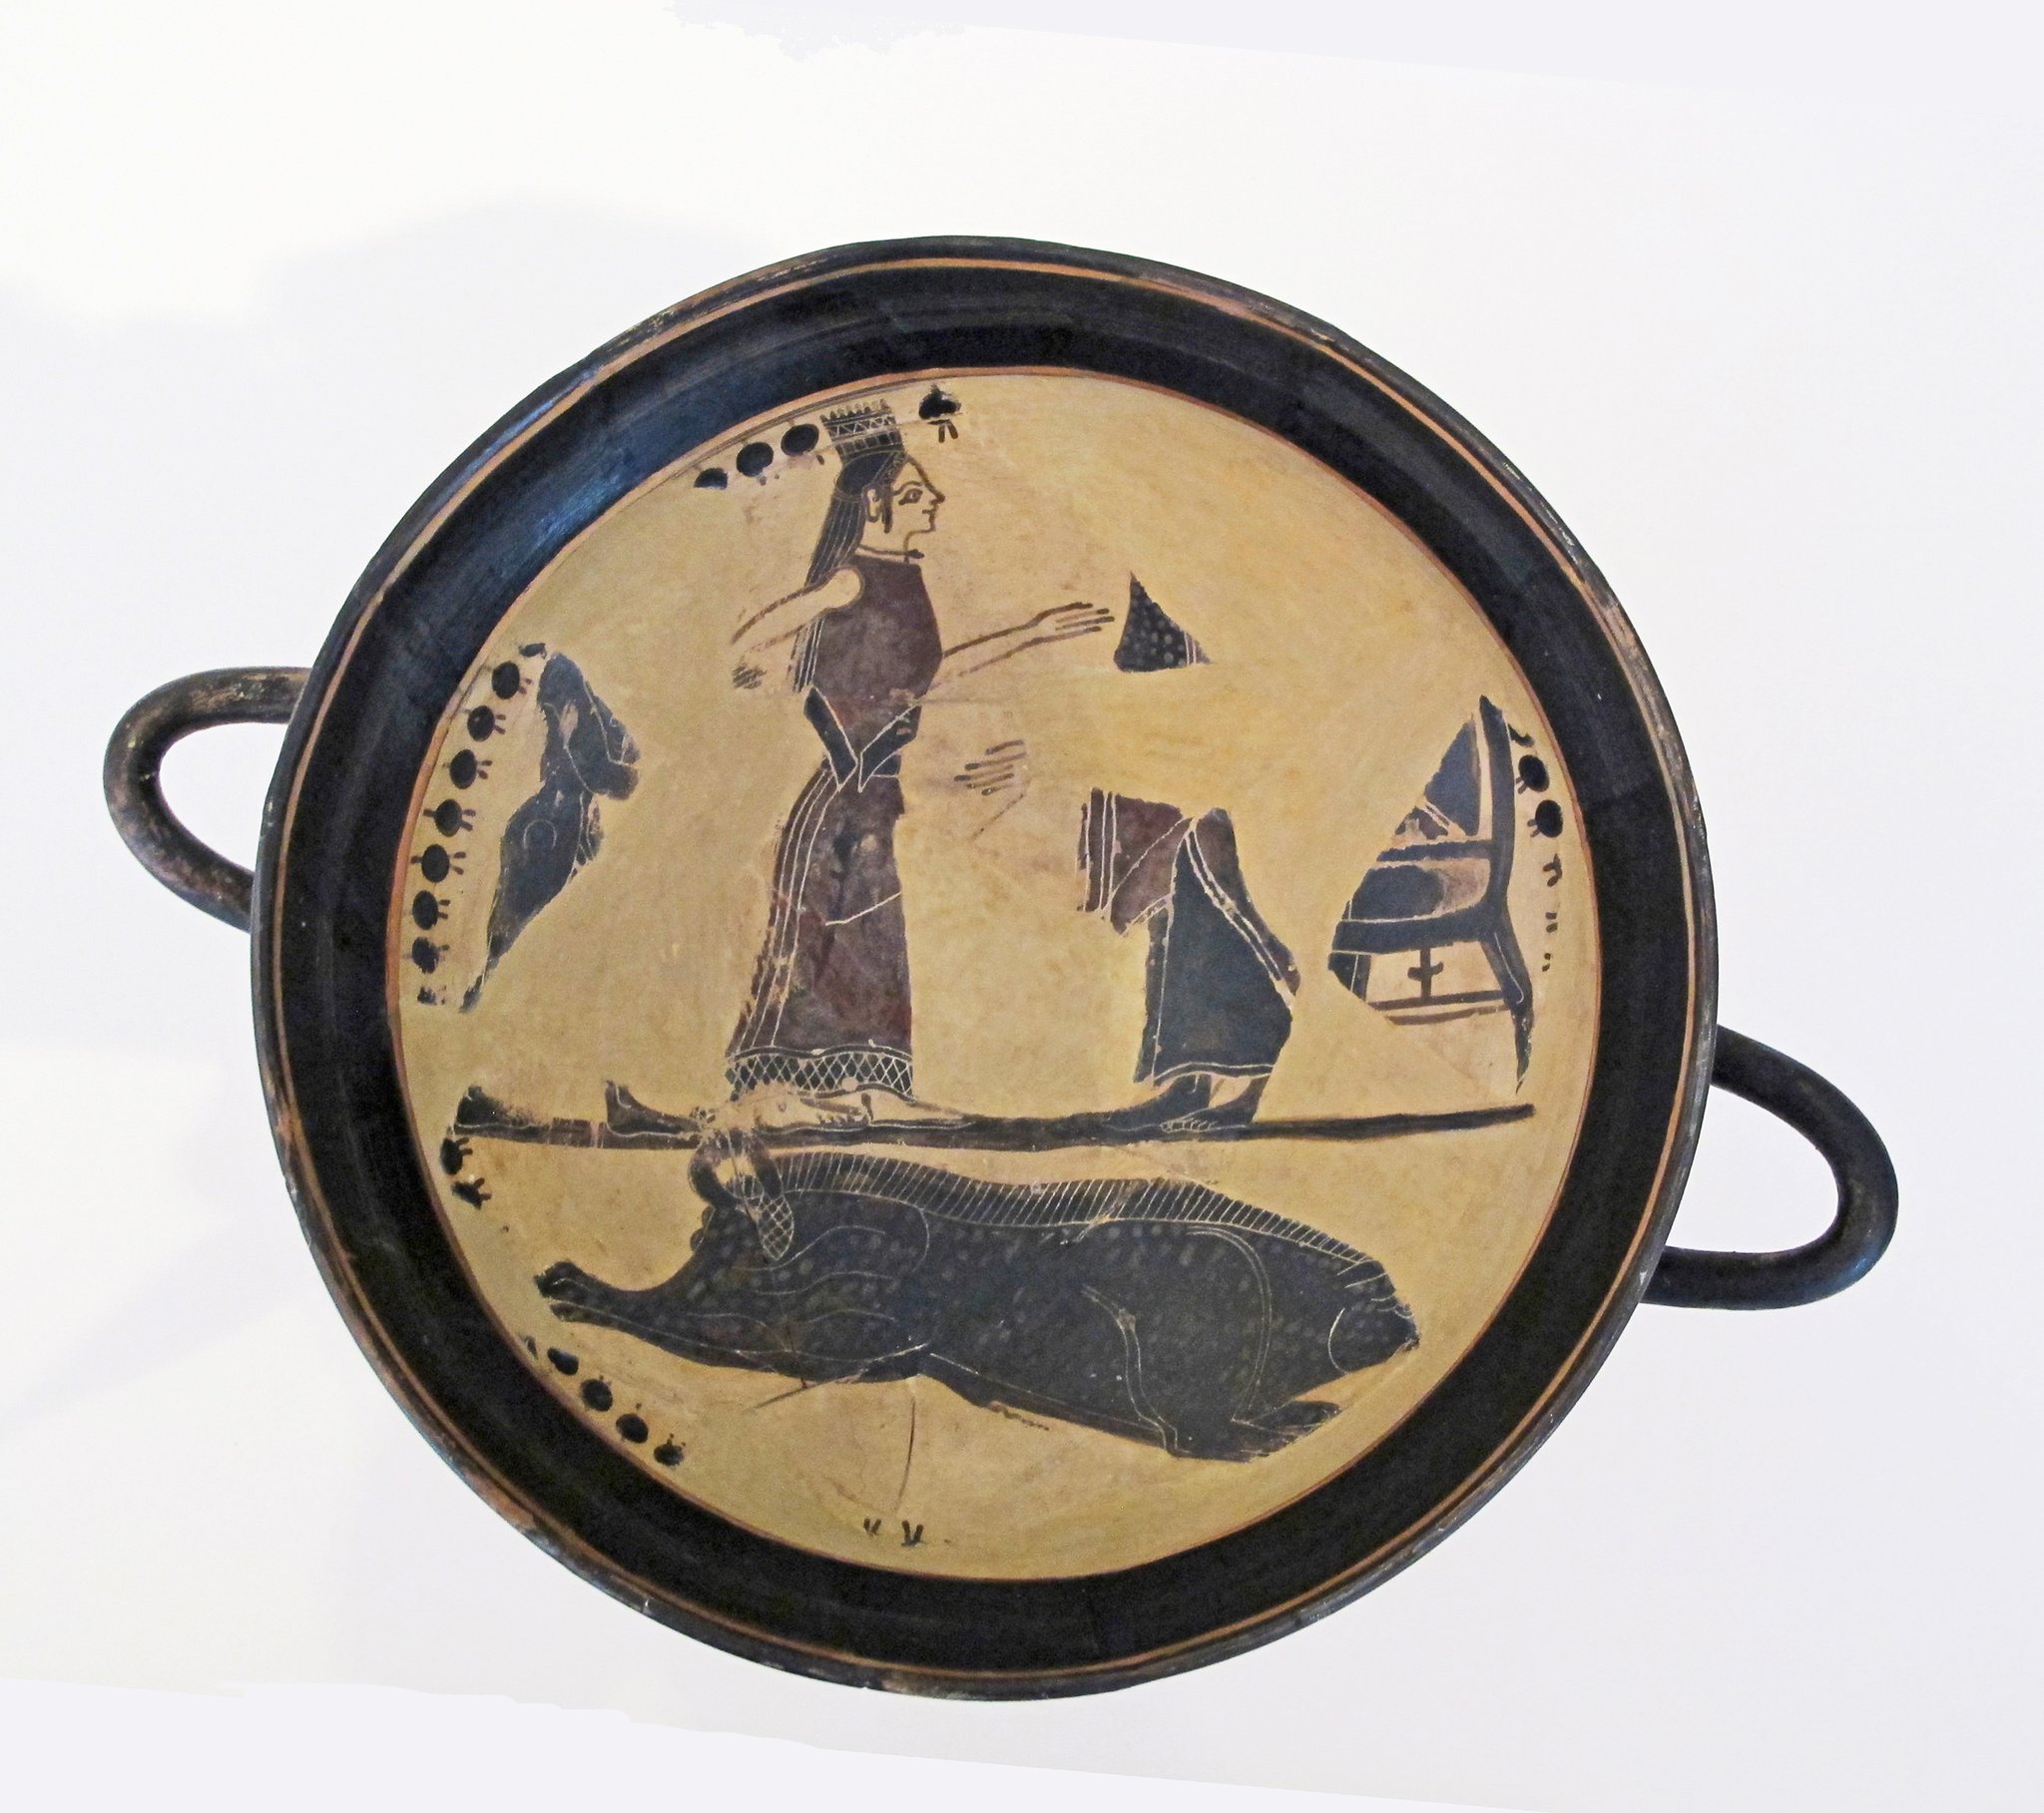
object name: kylix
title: Terracotta kylix (drinking cup)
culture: greek, laconian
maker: boreads painter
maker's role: artist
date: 570-560 BCE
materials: terracotta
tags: athena,boars